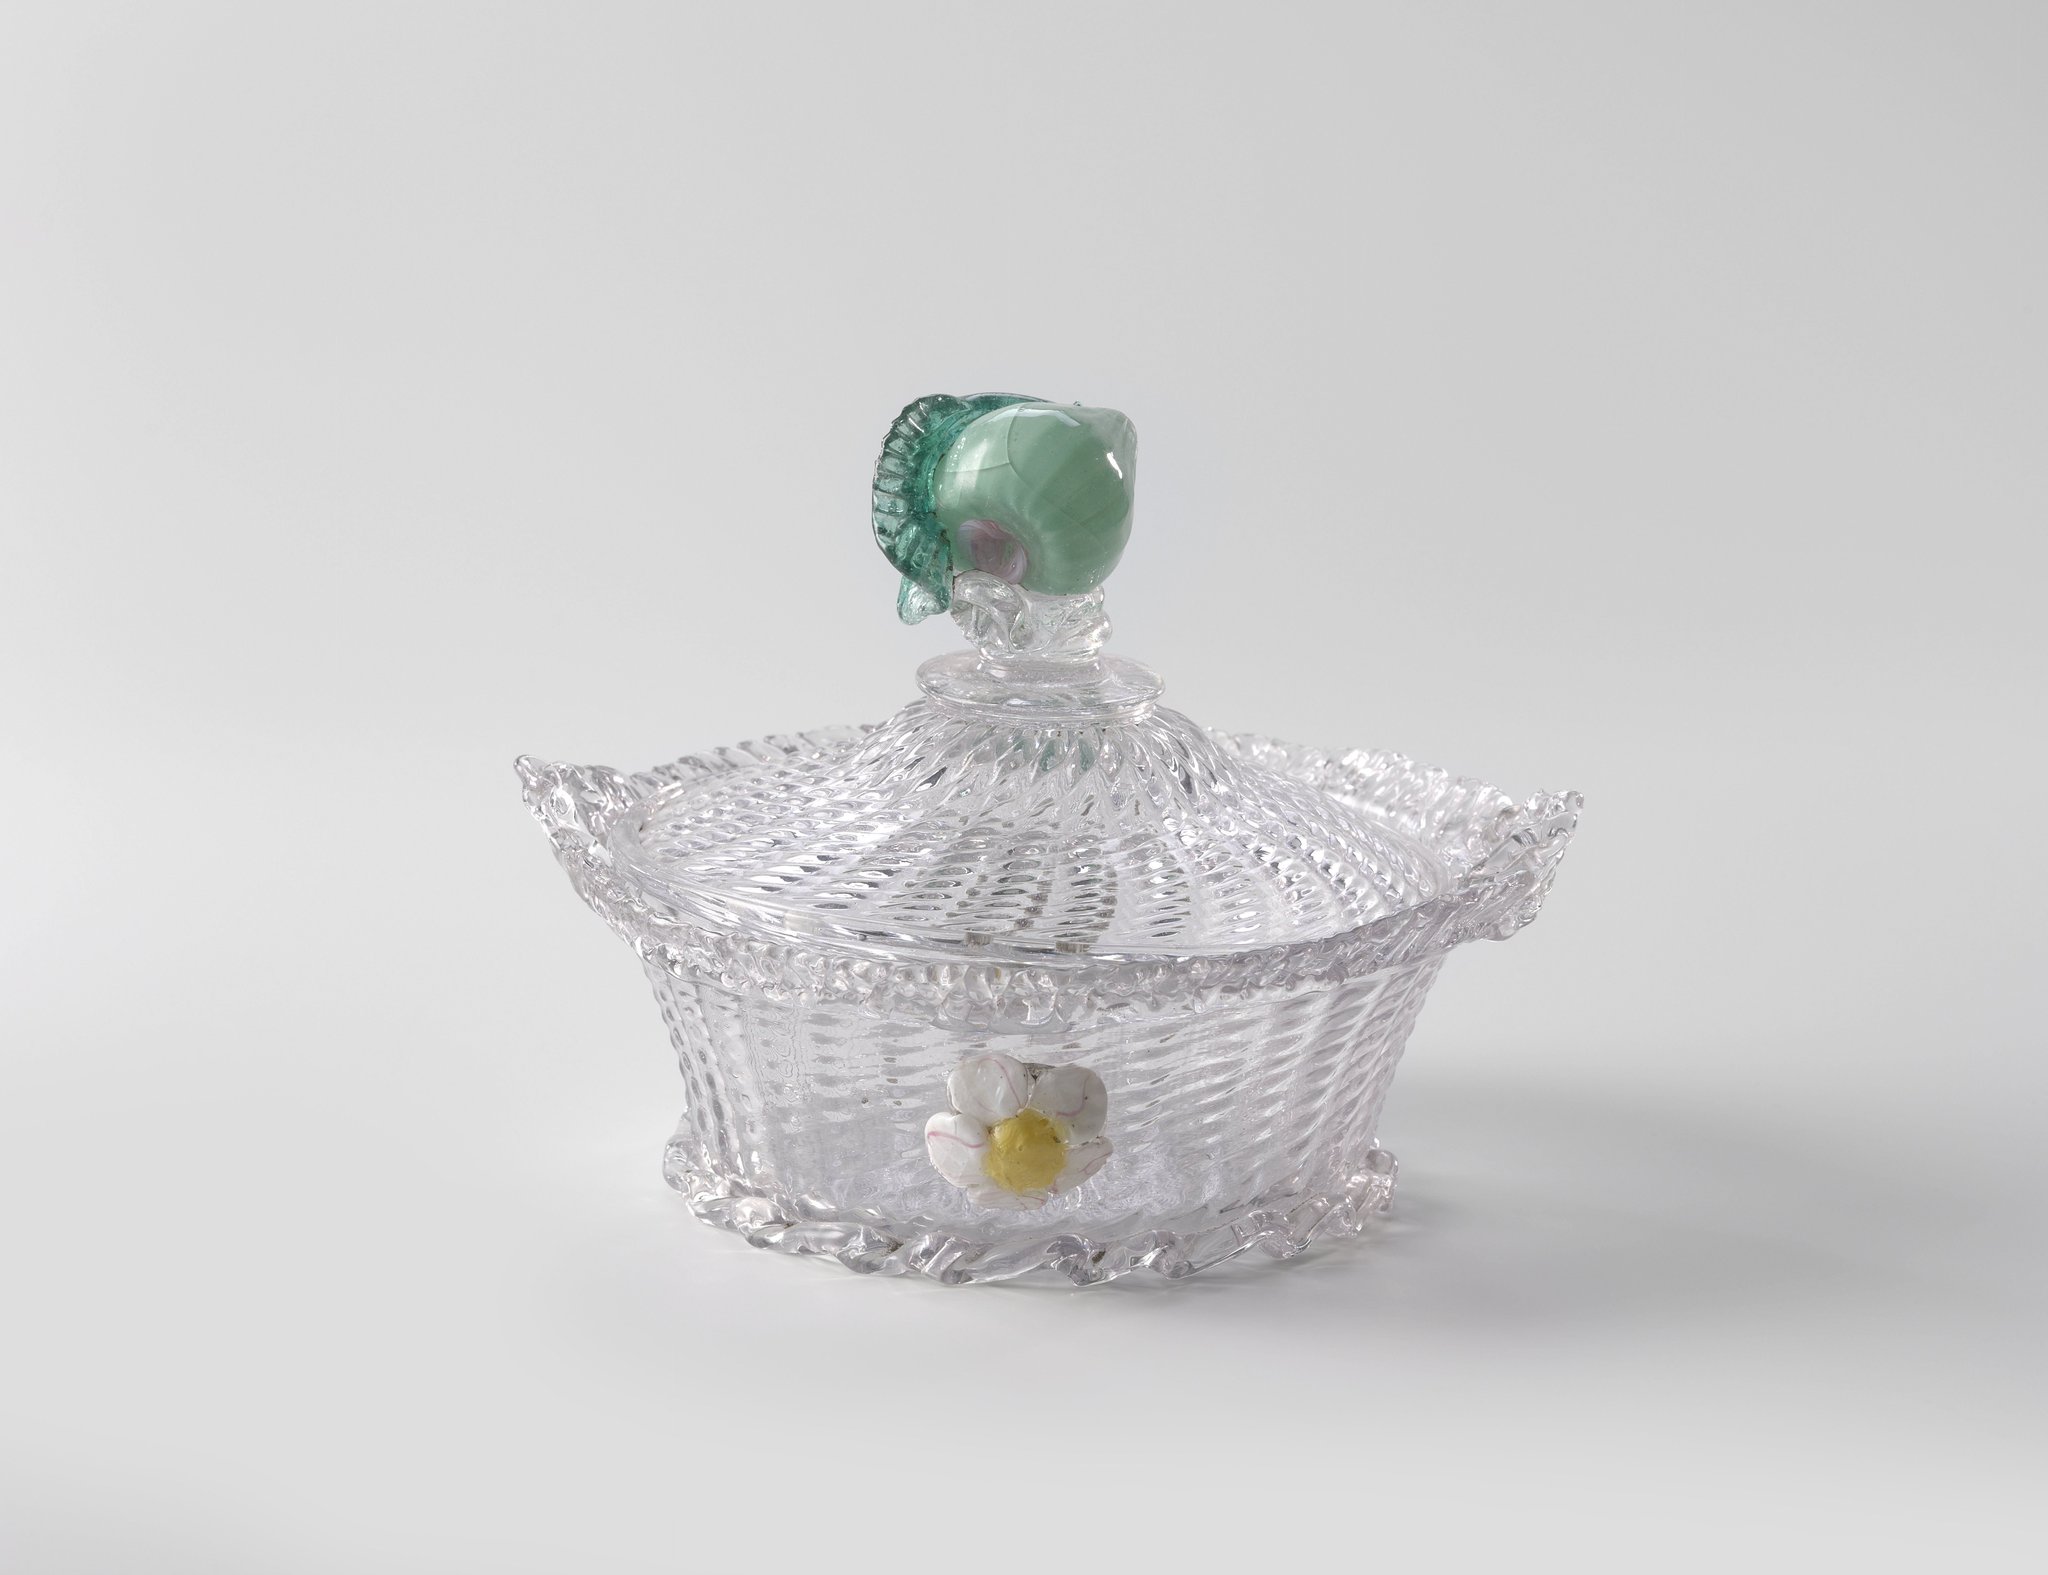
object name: dish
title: Schaal met deksel in de vorm van een mand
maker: Anonymous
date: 1700-1800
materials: glass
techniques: glassblowing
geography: venice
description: Schaal met deksel op gegolfde standring. Lichaam en deksel in de vorm geblazen in een vlechtwerkpatroon. Aangezette, geribde rand. Twee oren van een gegolfde draad. Gewelfd deksel in eenzelfde vlechtwerkpatroon, afgezet met een gladde draad. Op het lichaam twee opaak witte bloemen met een paars hart en groene, paars generfde bladeren. Het deksel wordt bekroond door een geribde peer van groen opaak glas, met een geknepen blad van helder groen glas